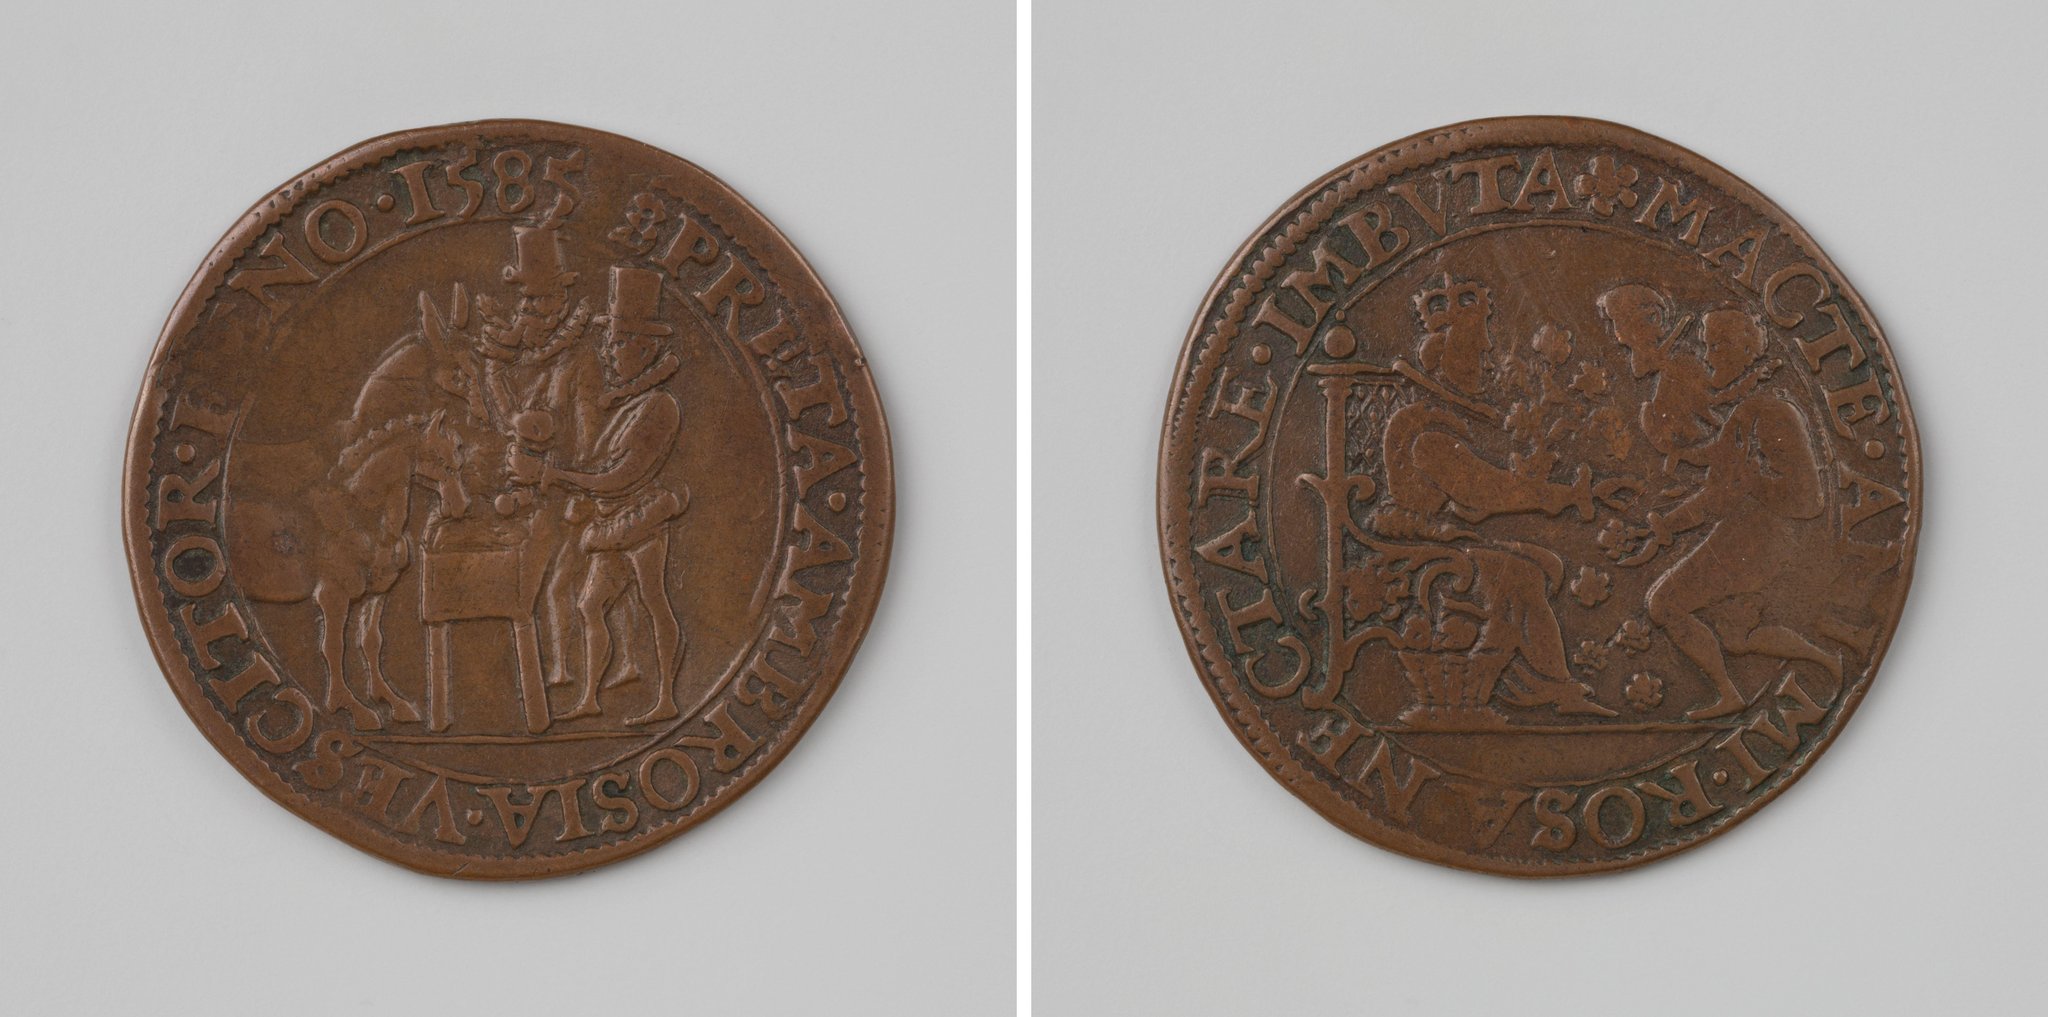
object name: jeton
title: Afwijzing van de soevereiniteit over de Verenigde Nederlanden door Engeland en Frankrijk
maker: Anonymous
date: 1585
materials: copper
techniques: striking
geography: dordrecht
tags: greenwich, richmond (surrey), koningin, elizabeth i tudor (koningin van engeland), tachtigjarige oorlog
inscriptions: circumscription: ‘SPRETA AMBROSIA VERCITOR FENO 1585’, circumscription: ‘MACTE ANIMI ROSA NECTARE IMBVTA’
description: Koperen penning. Voorzijde: twee mannen eten hooi met een ezel en een paard binnen omschrift. Keerzijde: zittende vrouw, voorstellende Elisabeth, koningin van Engeland, geeft rozen aan twee Staatse afgezanten binnen omschrift.